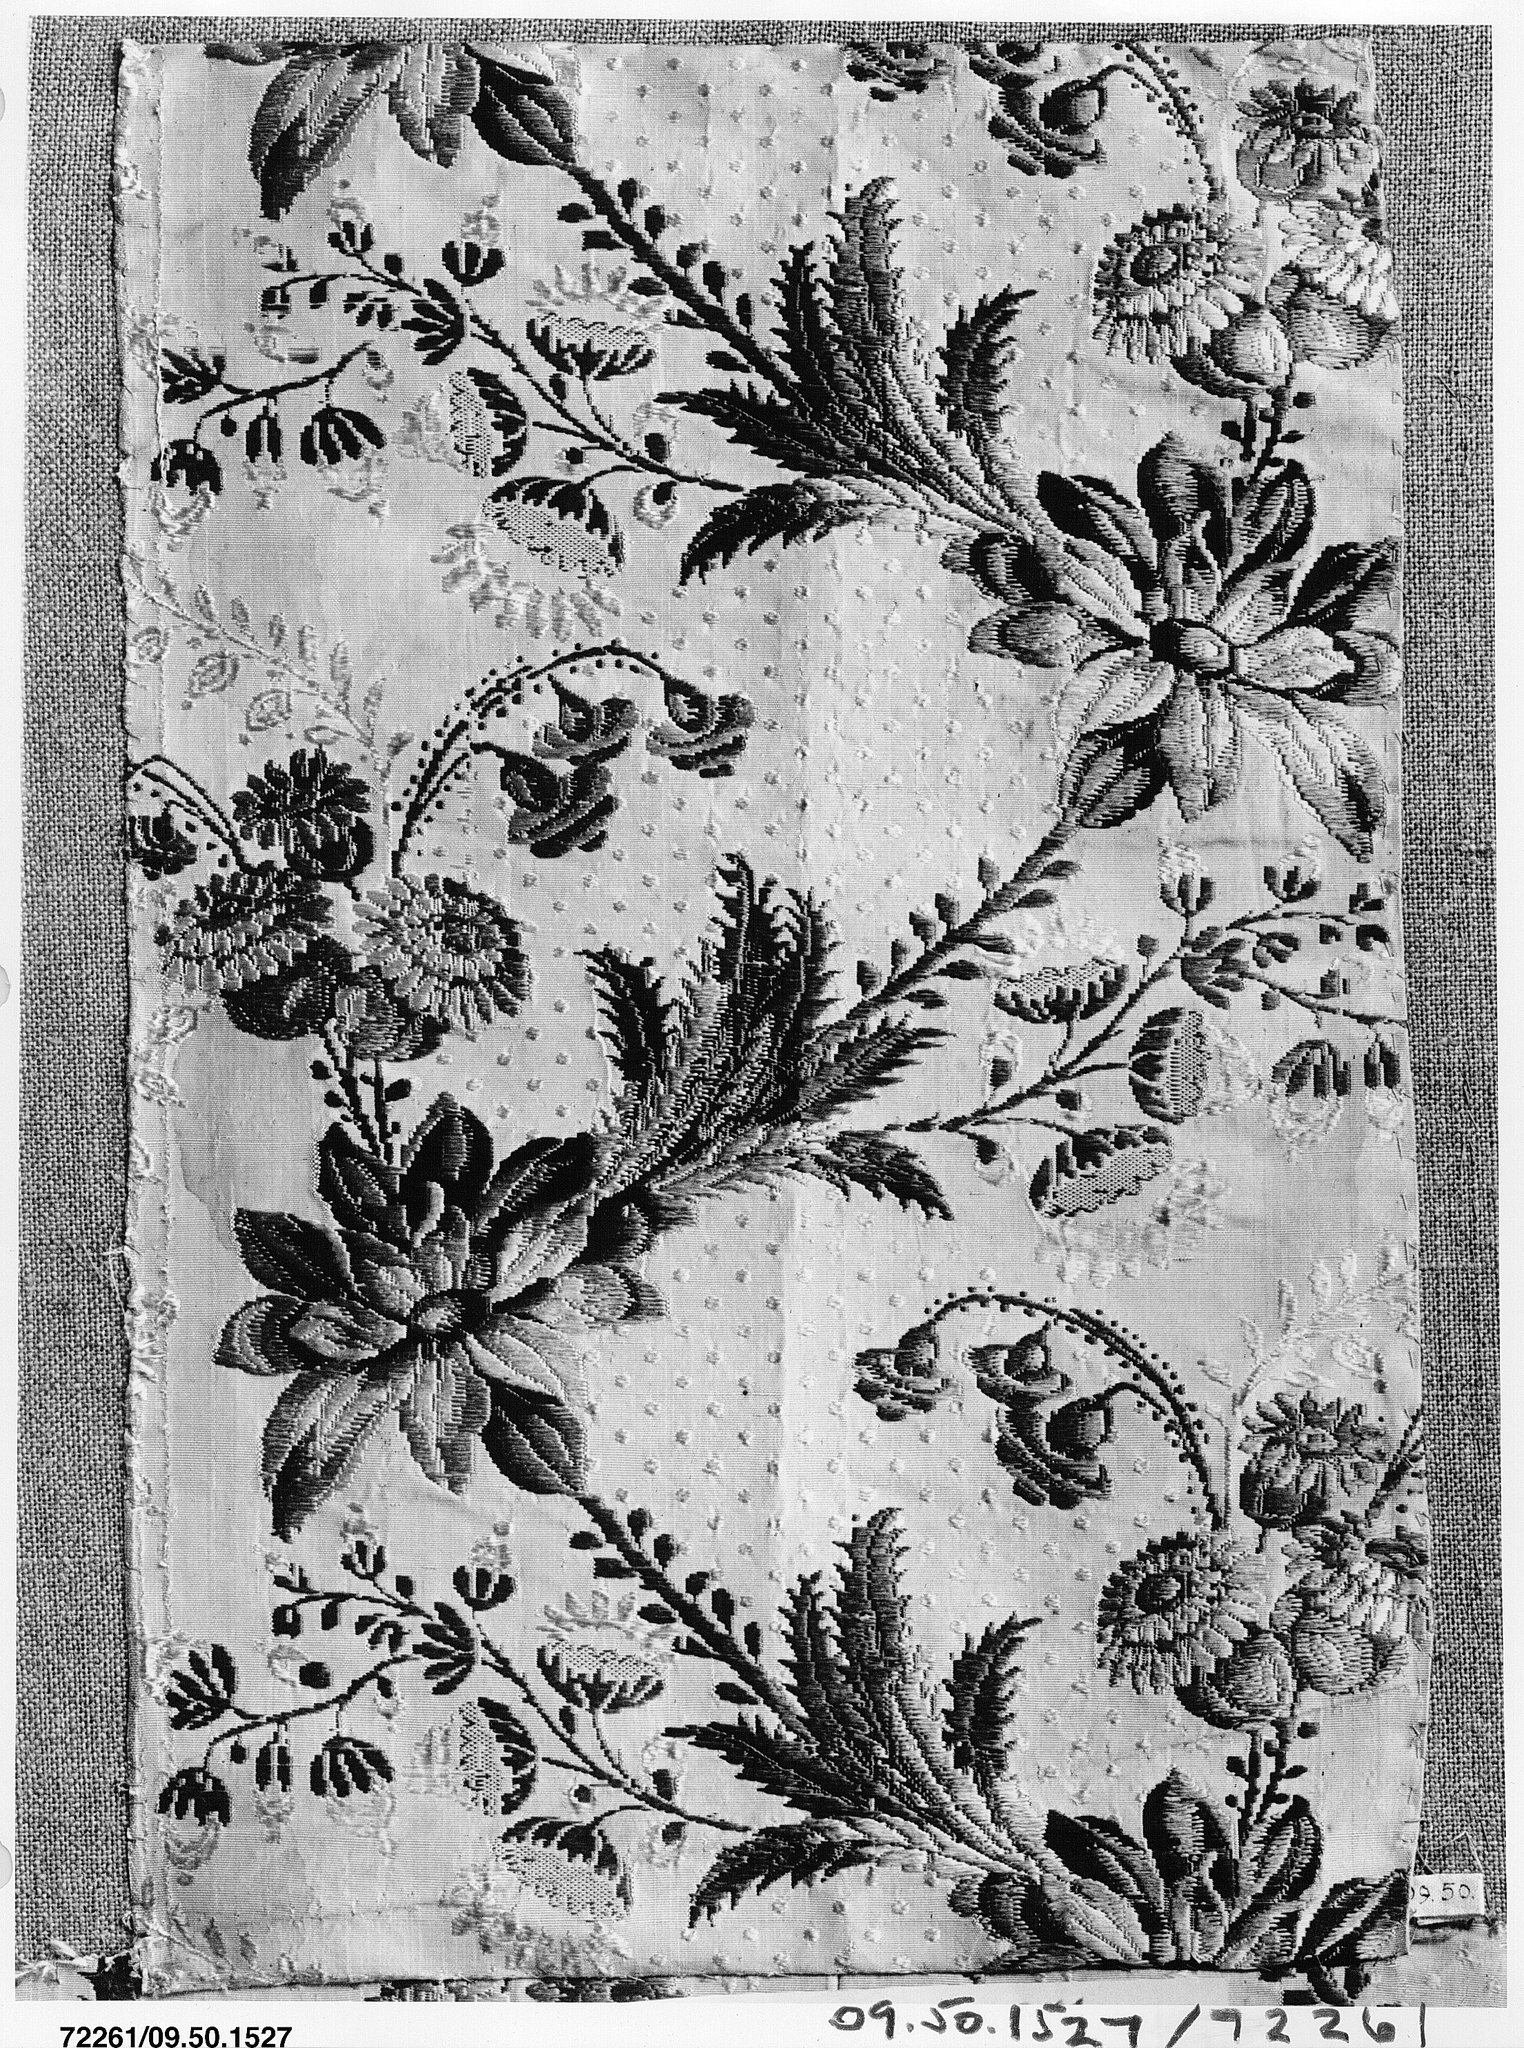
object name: piece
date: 1760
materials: silk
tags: flowers,leaves